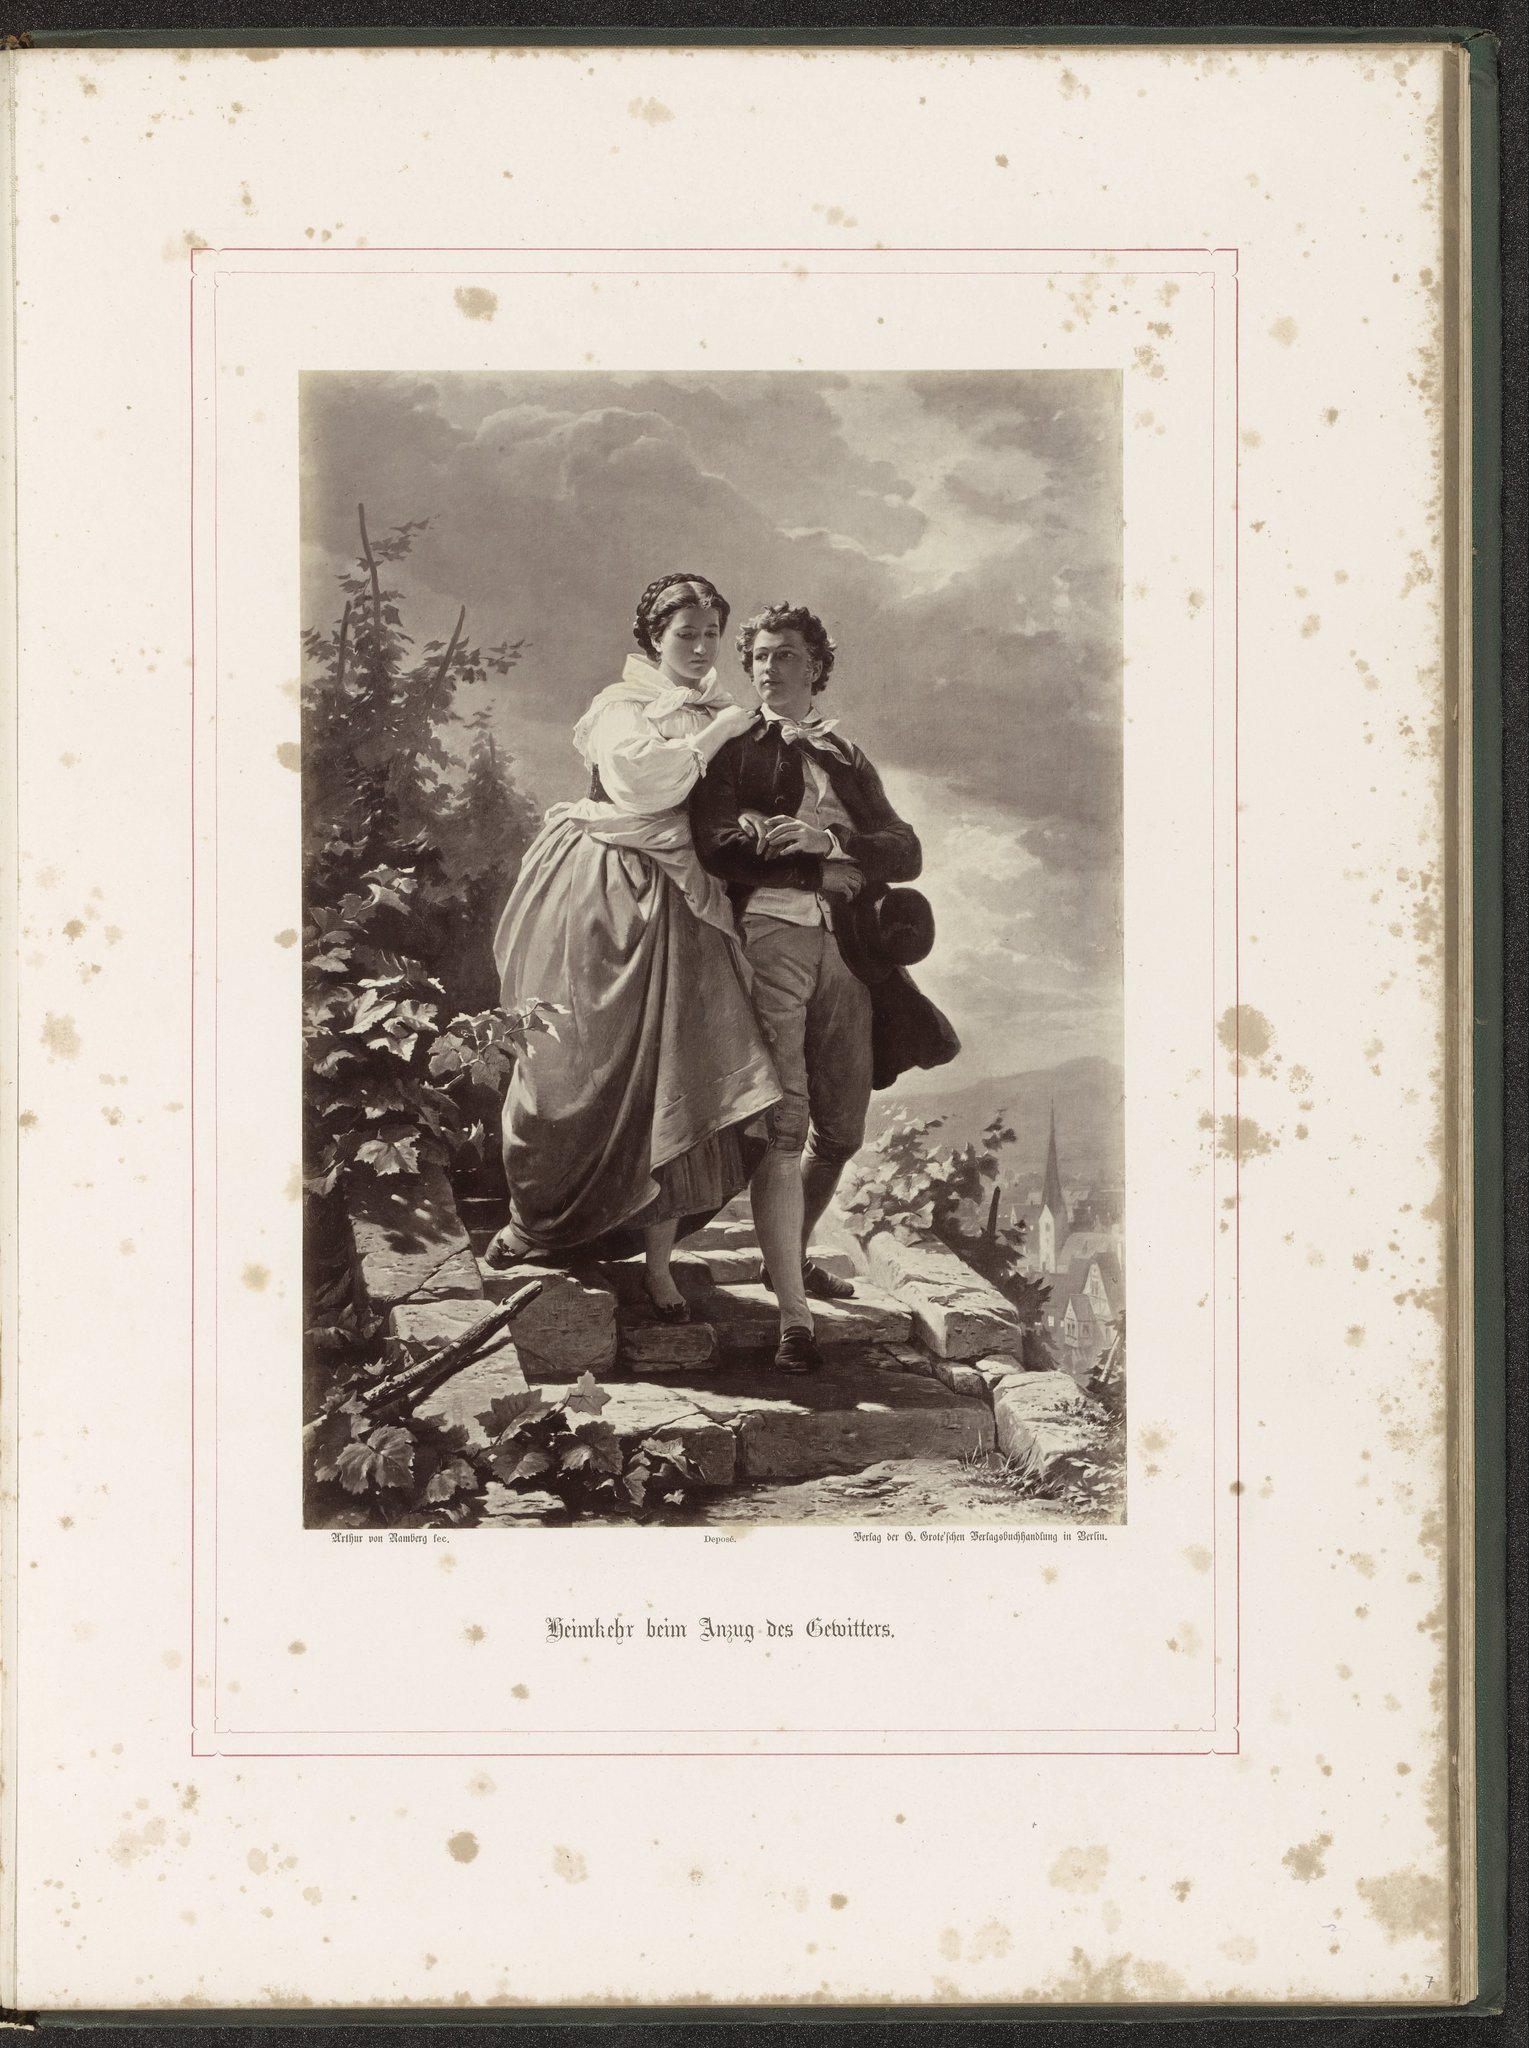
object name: photograph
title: Heimkehr beim Anzug des Gewitters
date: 1871-1872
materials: photographic support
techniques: albumen print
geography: berlin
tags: adolescent, young woman, maiden, youth, adolescent, couple of lovers, storm on land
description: Onderdeel van Album met fotoreproducties van schilderijen van A.G. von Ramberg naar het werk 'Hermann und Dorothea' van J.W. von Goethe.